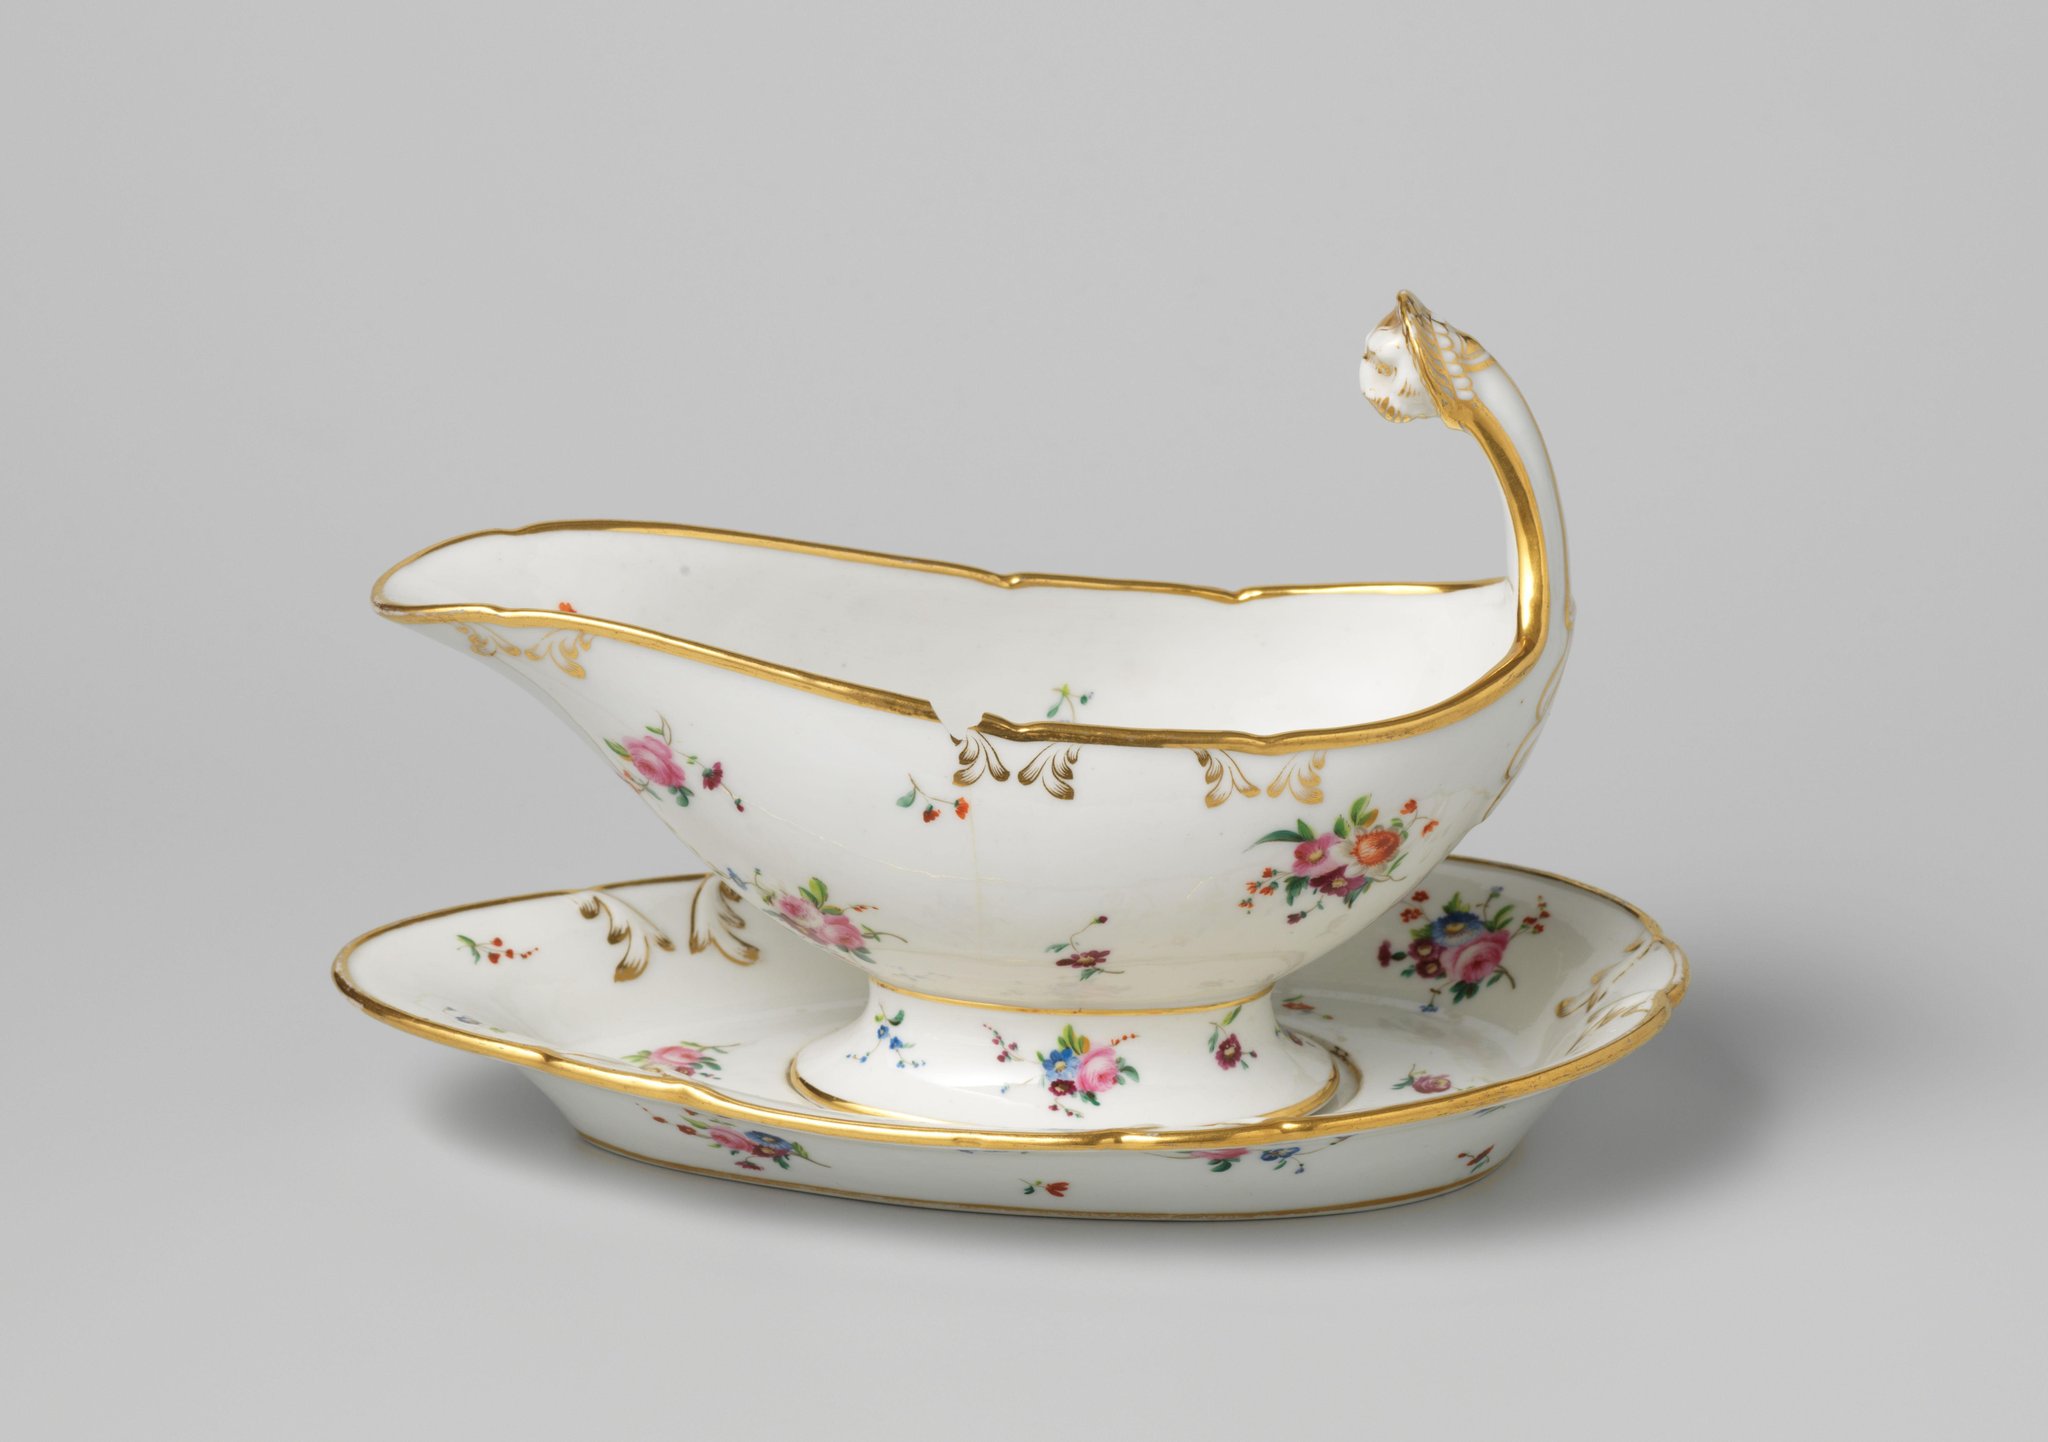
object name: sauceboat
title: Saus bowl with bouquets and flower sprays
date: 1839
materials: glaze, gold, paint, porcelain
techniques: firing, forming, gilding, turning, vitrification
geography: paris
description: Sauskom van porselein met een gelobde rand, beschilderd op het glazuur in blauw, rood, roze, groen, geel, paars, zwart en goud. De kom is ovaal, op een hoge, spreidende voet en met aan de ene zijde vanuit de rand een handvat eindigend in een leeuwenkop en aan de andere zijde een brede schenkrand. Versierd op de binnen- en buitenzijde met verschillende bloemen en strooibloemen. Vanuit de gelobde, gouden rand, bladranken in goud op de buitenwand. Gouden lijn boven de voet. Rand en voet van de kom beschadigd.